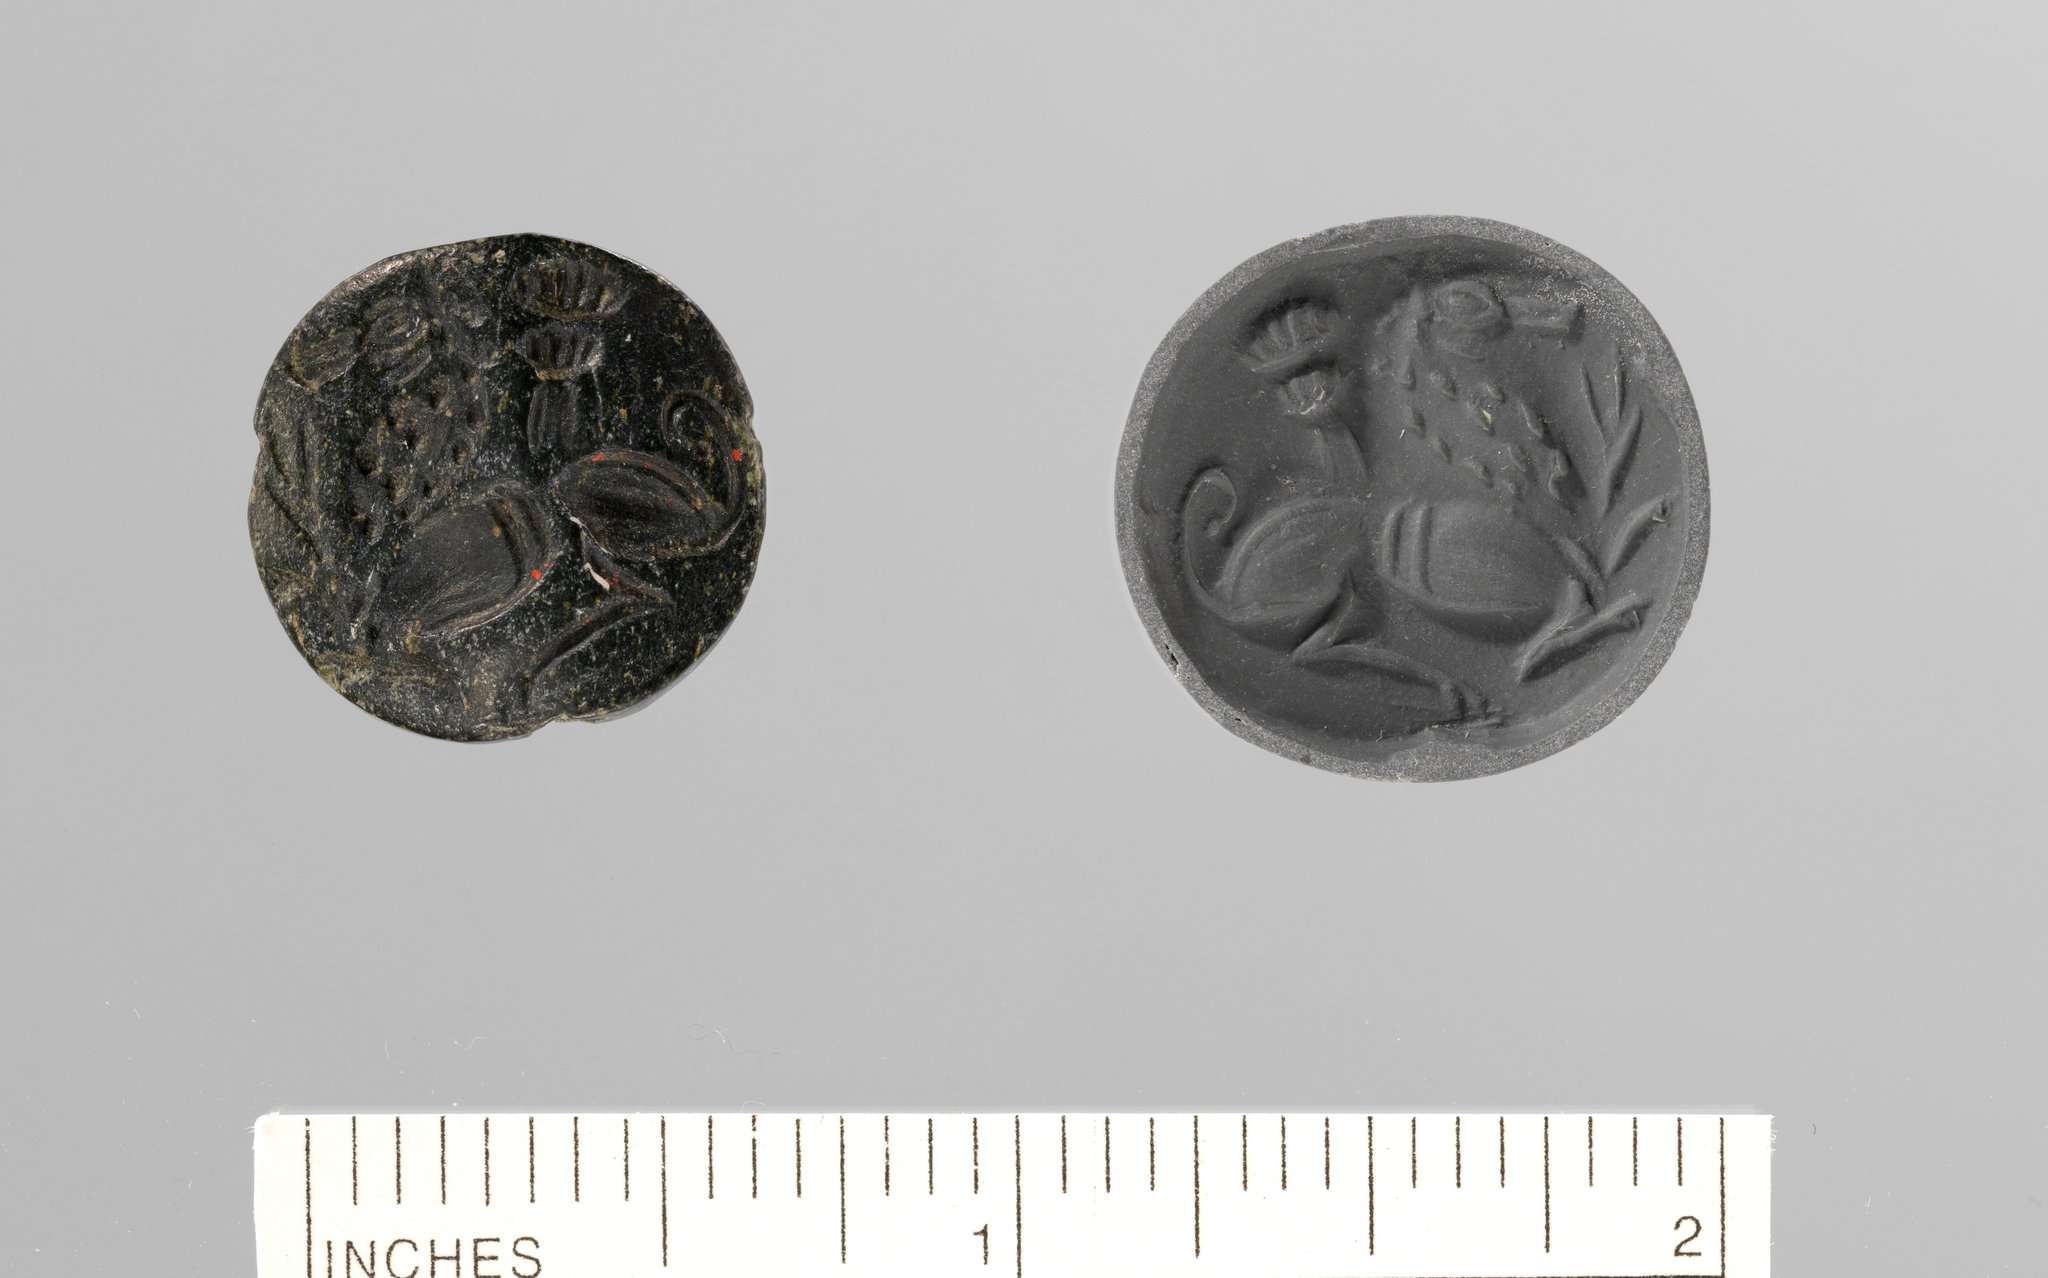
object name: seal, lentoid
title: Steatite Lentoid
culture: minoan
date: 1350-1200 BCE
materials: stone